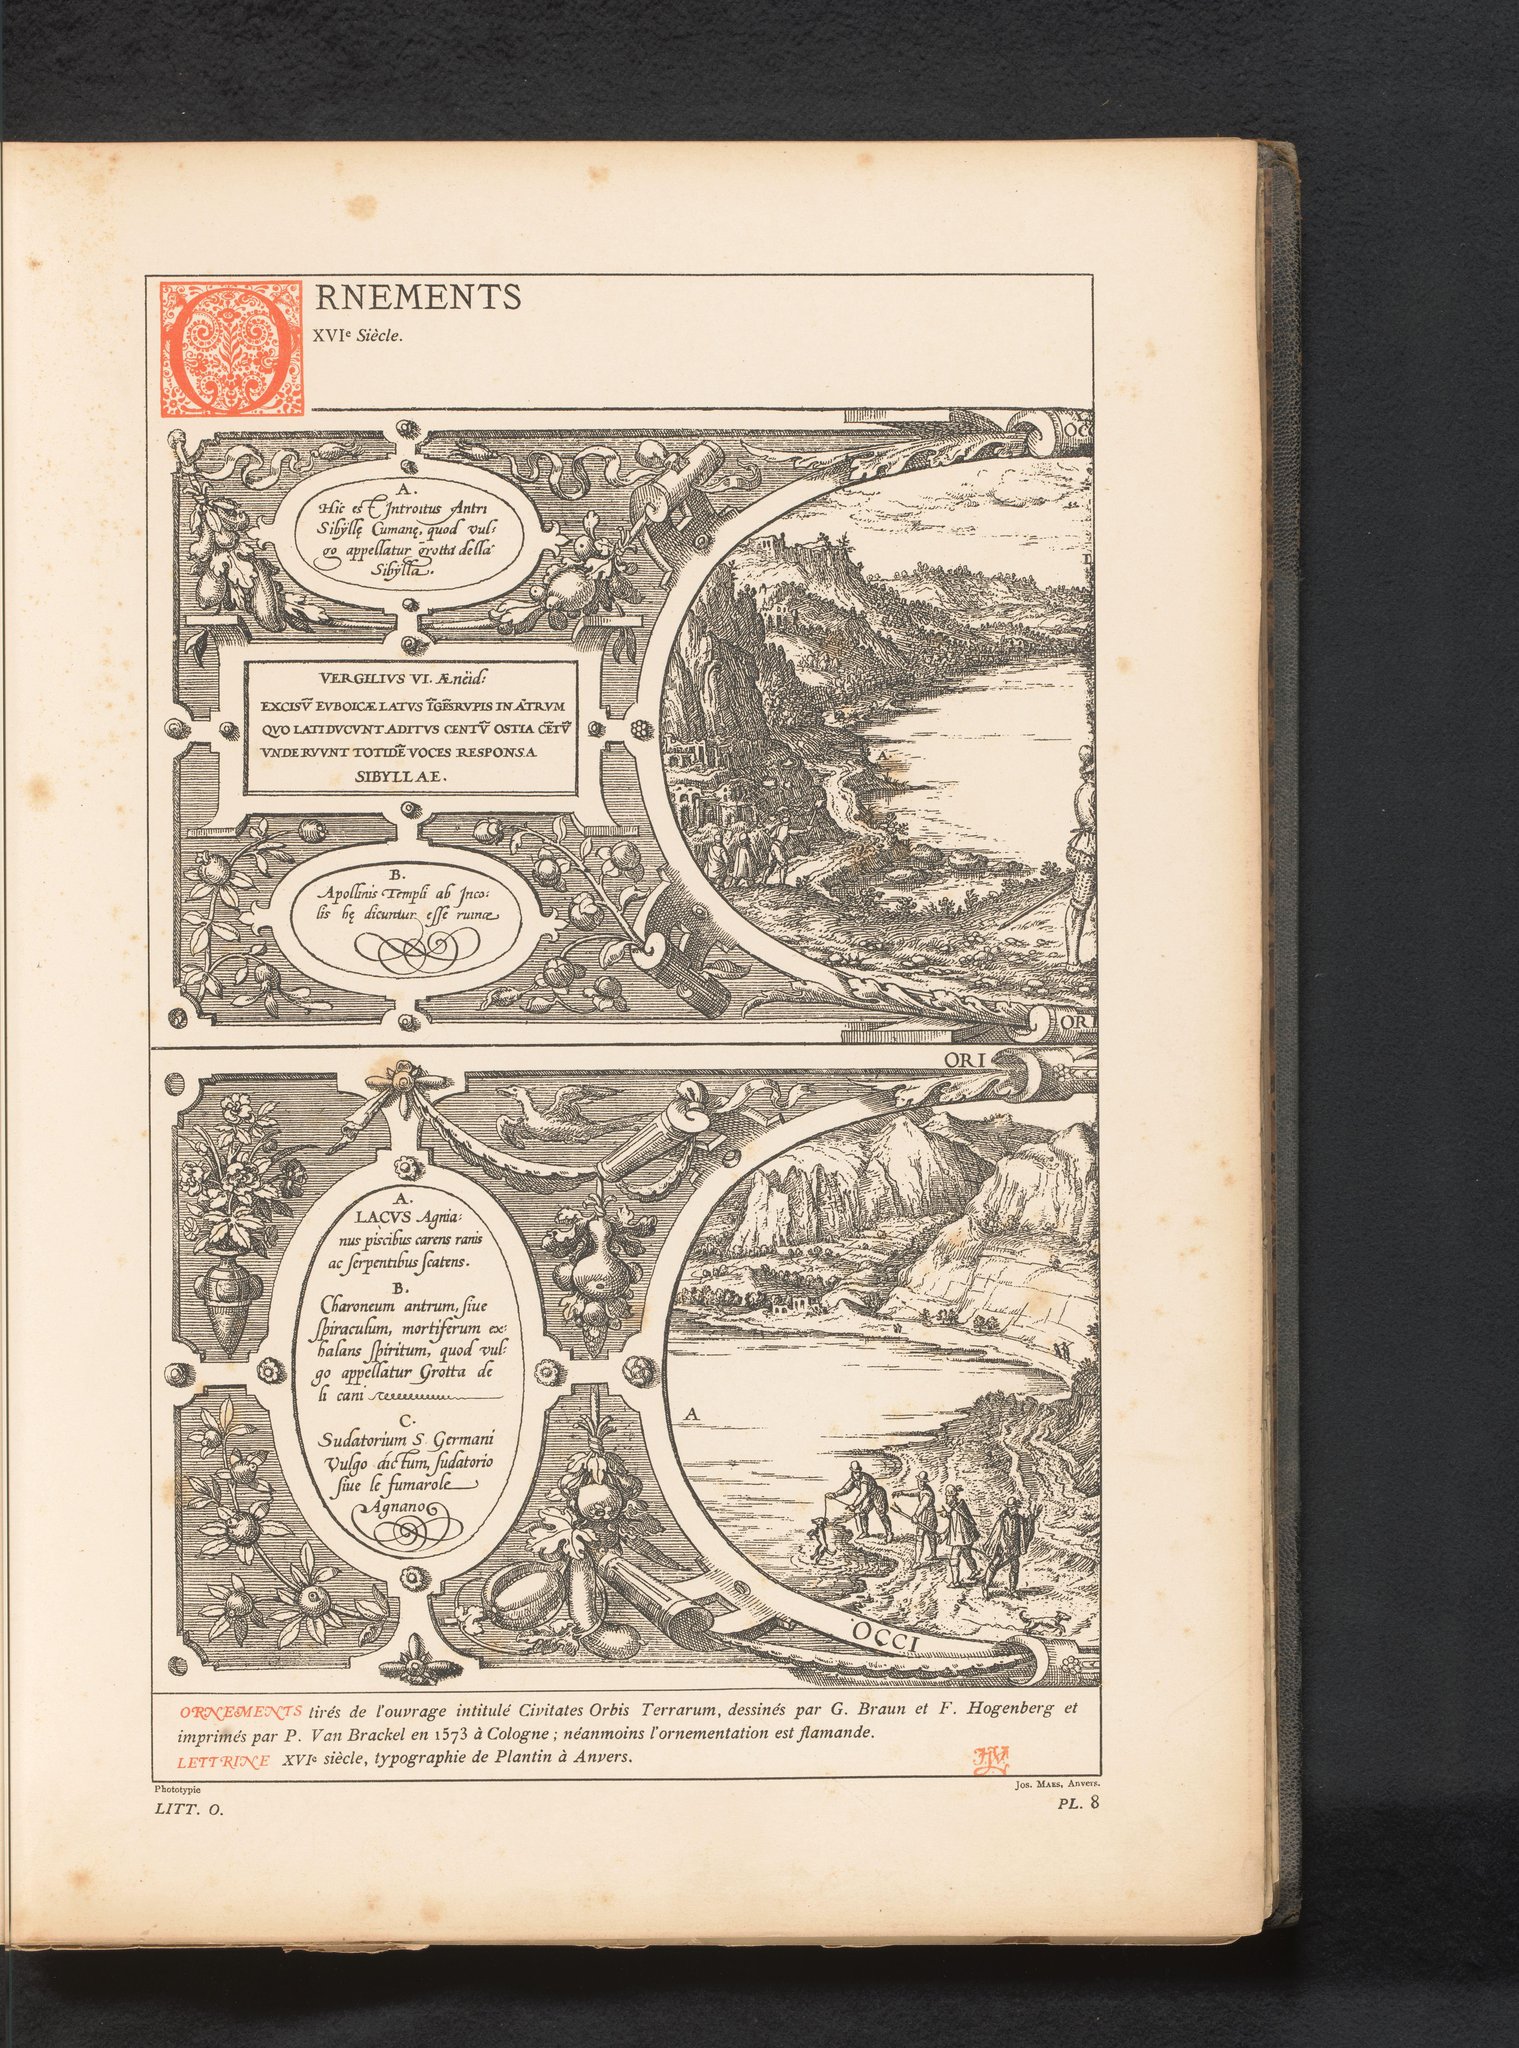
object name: reproduction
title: Reproductie van een prent uit Civitates Orbis Terrarum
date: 1876-1881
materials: paper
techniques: photolithography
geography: antwerp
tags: ornaments ~ art, landscapes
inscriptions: monogram: ‘JJvY’, inscription: ‘LITT. O. - PL. 8’, inscription: ‘ORNEMENTS tirés de (...)’